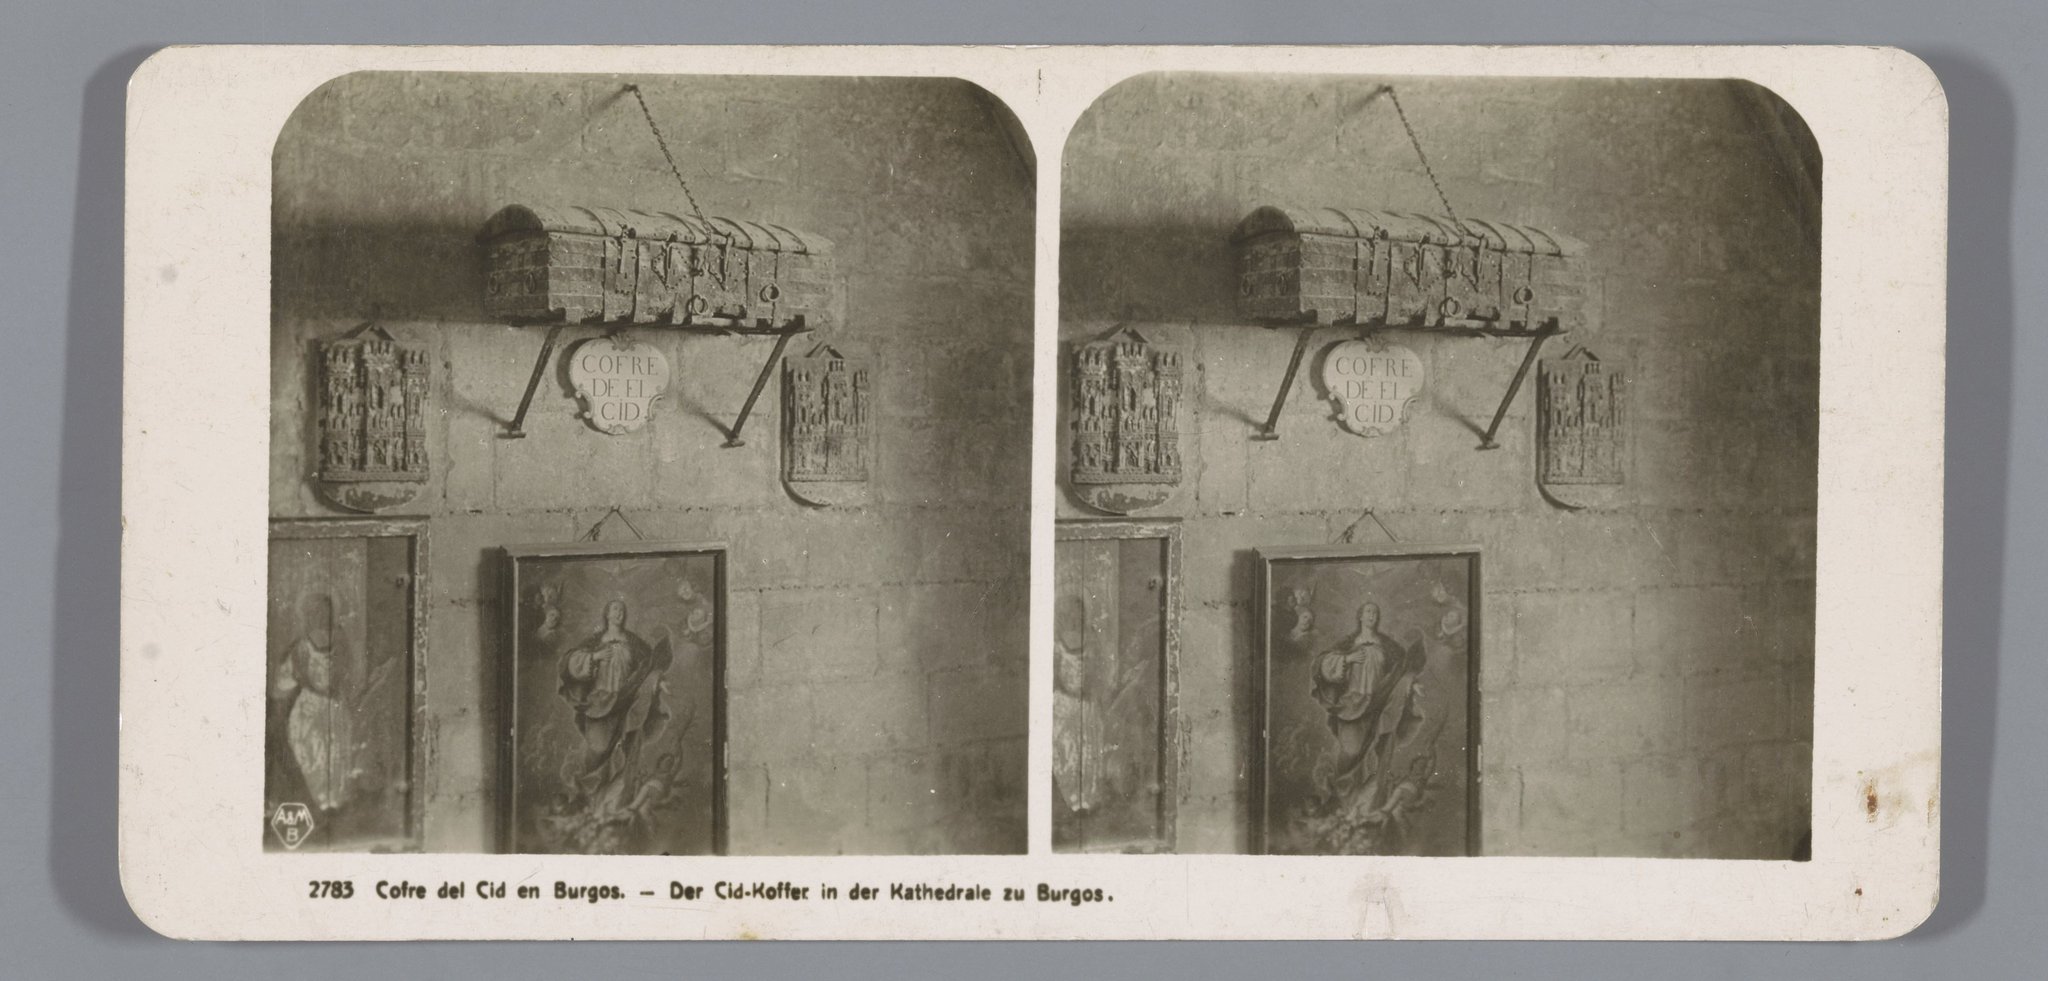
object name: stereograph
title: Kist van El Cid in de Kathedraal van Burgos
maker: Anonymous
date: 1890-1920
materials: cardboard, photographic support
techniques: gelatin silver print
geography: burgos cathedral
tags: church (exterior), chest, coffer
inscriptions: annotation, number: ‘2783’